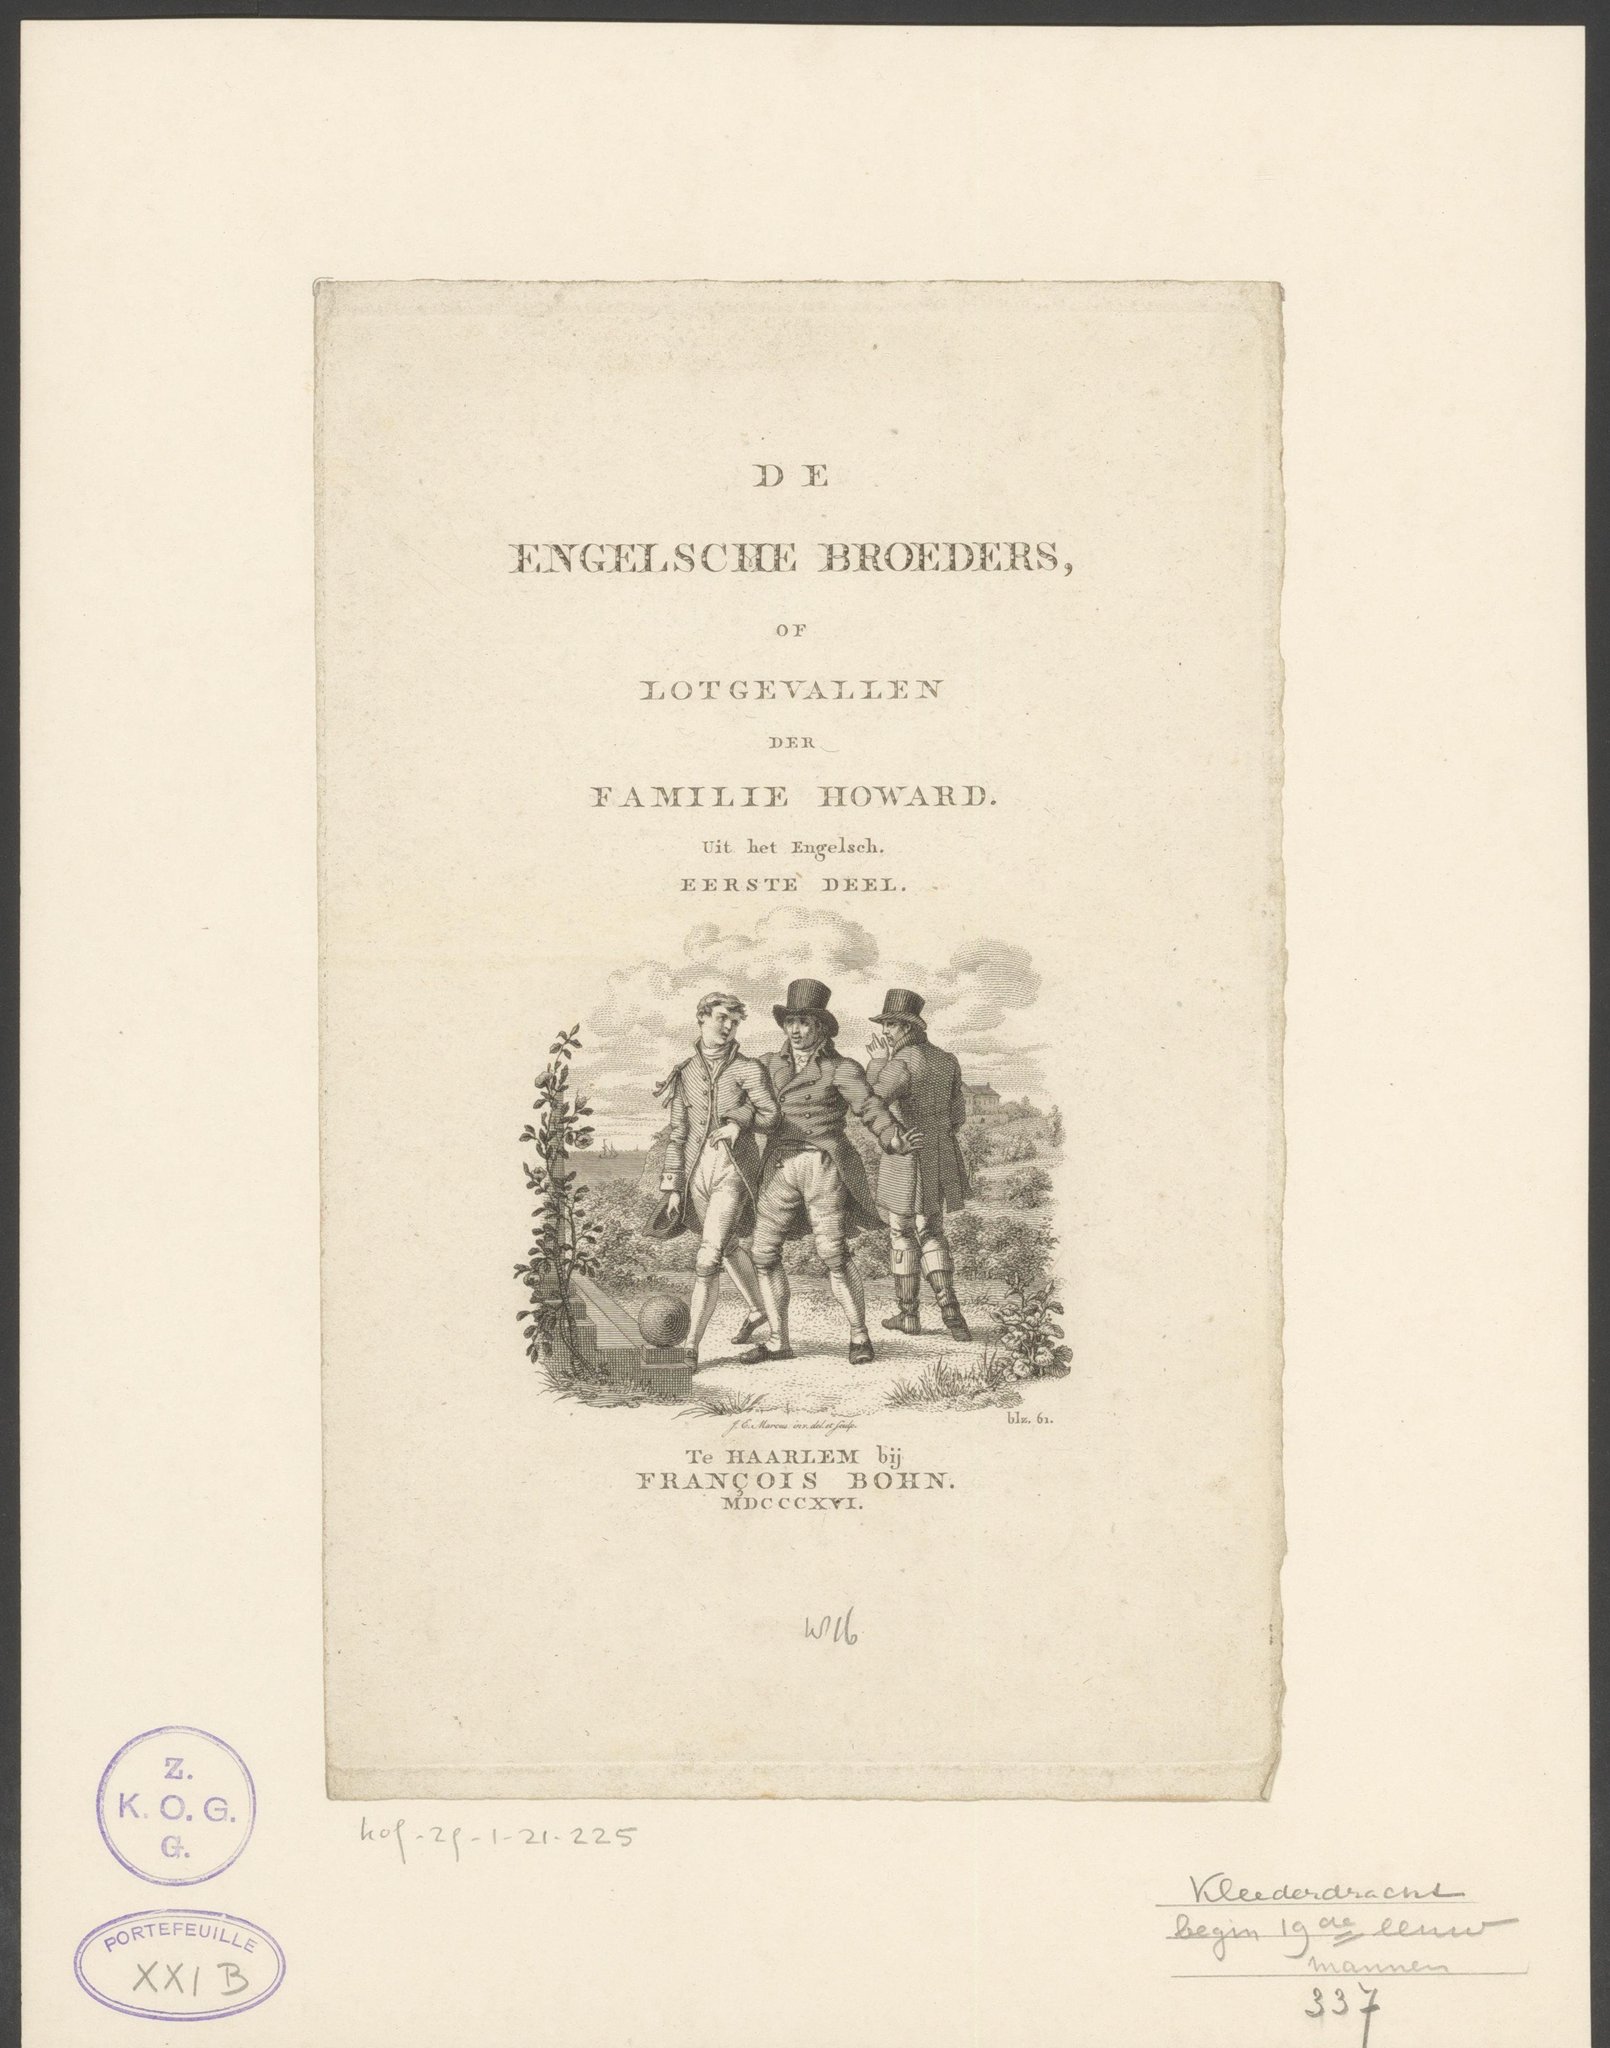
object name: print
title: Titelprent voor: De Engelsche broeders, of lotgevallen der familie Howard, 1816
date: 1816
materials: paper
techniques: etching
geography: haarlem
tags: garden, brothers (second degree family relationships)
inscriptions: collector's mark: Lugt 1641, stamp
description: Onderwerpsrubrieken binnen de Atlas Zeden en Gewoonten: Zeden en Gewoonten in Engeren Zin, De Kleeding, Kleederdrachten (tijdvakken), Het begin der 19de eeuw. Mannen en vrouwen.